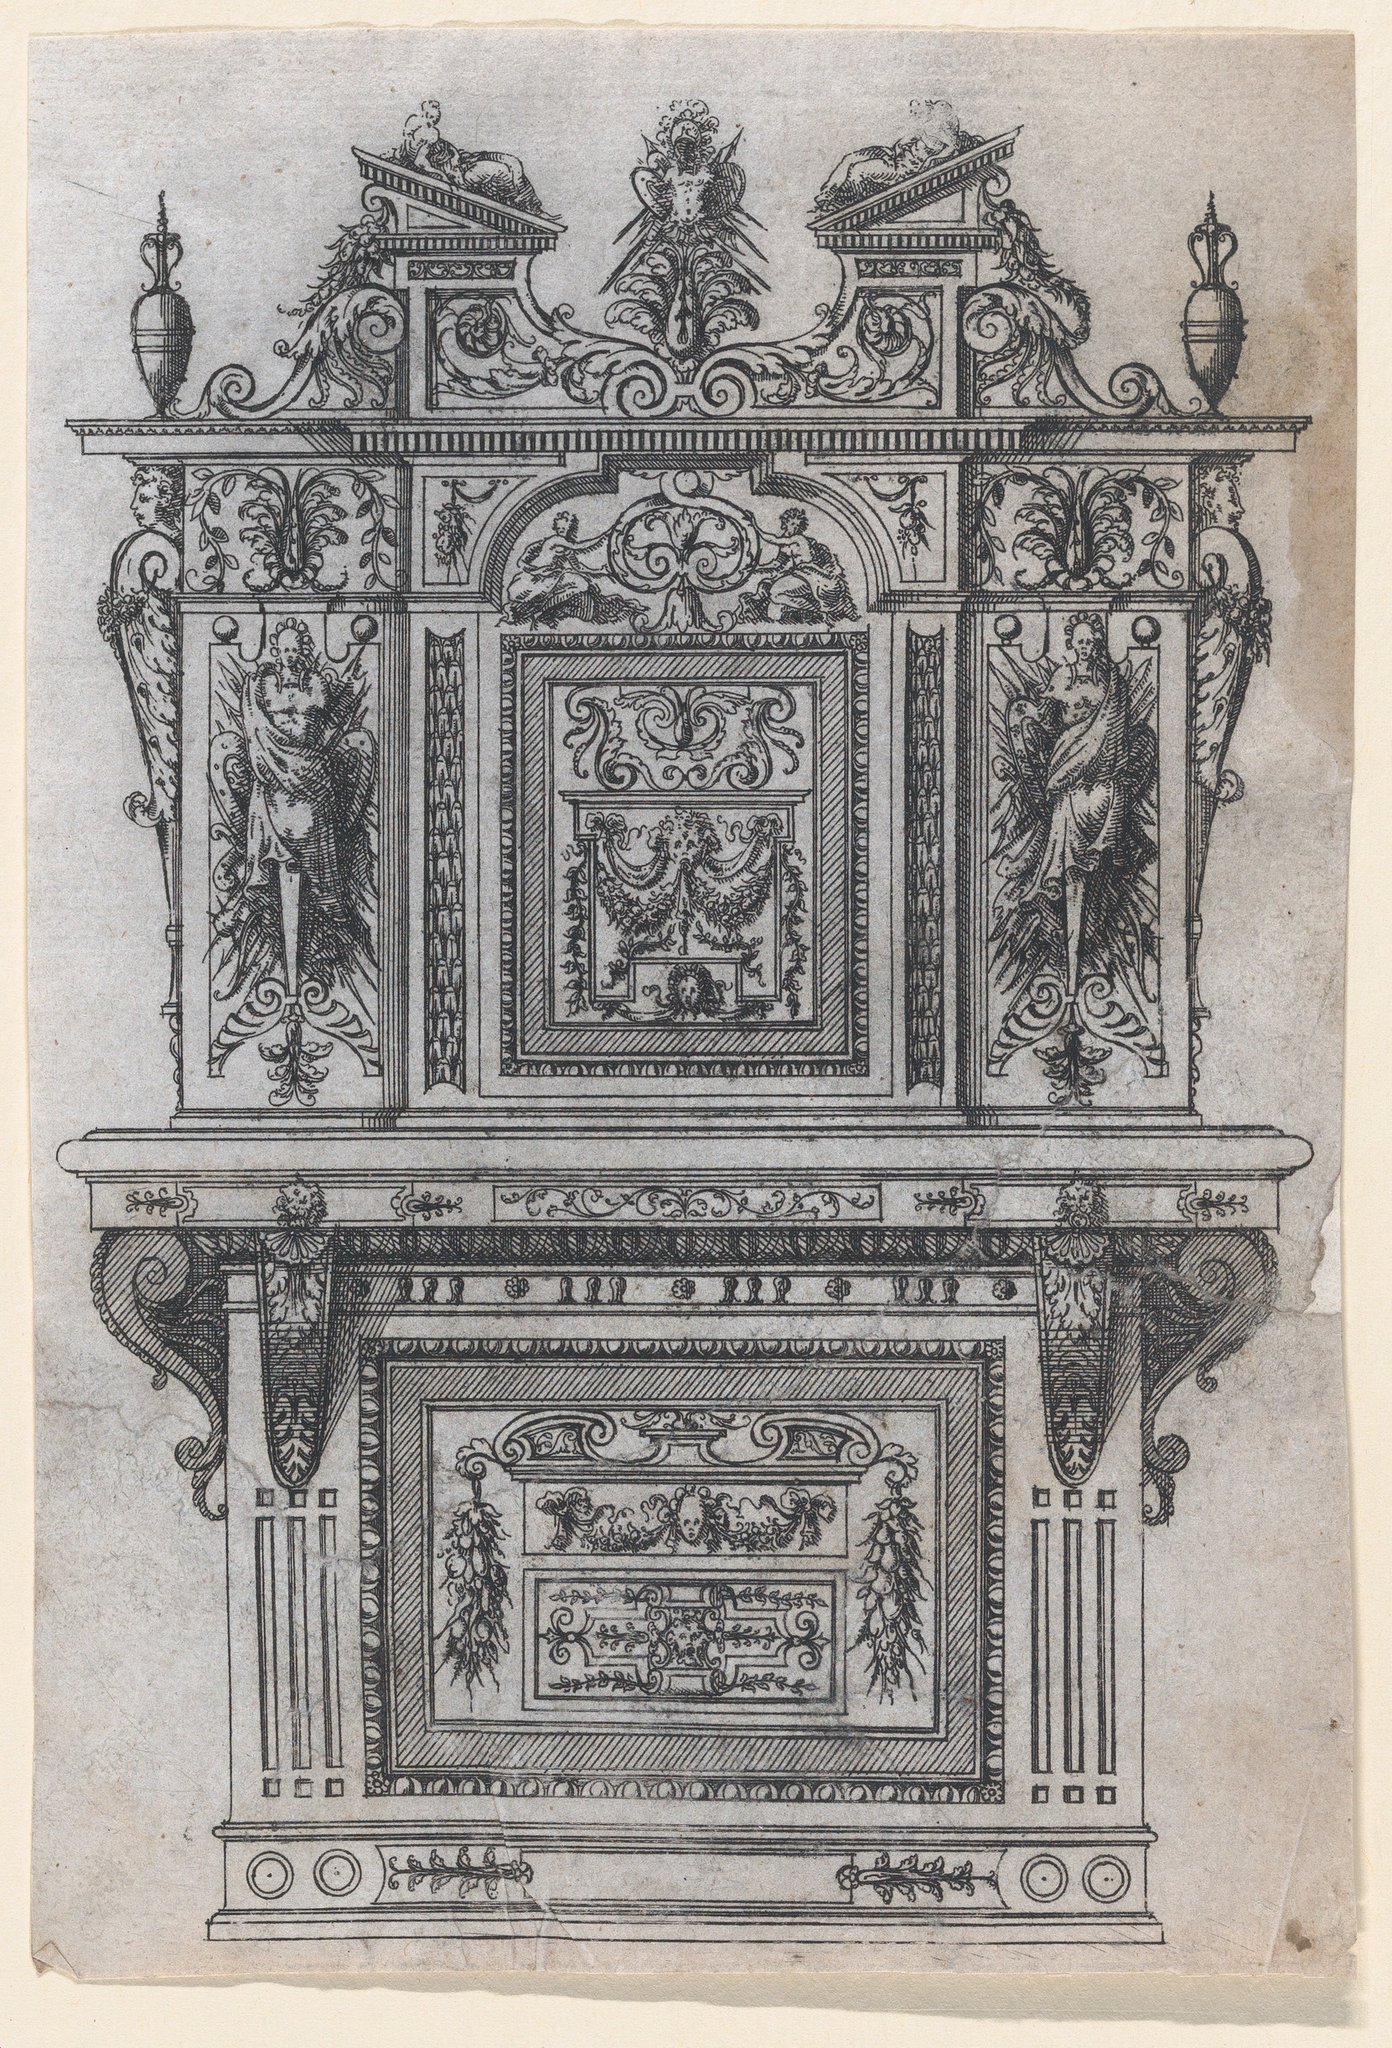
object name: print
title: Furniture Design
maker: jacques androuet du cerceau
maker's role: artist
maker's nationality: french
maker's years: 1510-1585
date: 1565-1570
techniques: etching